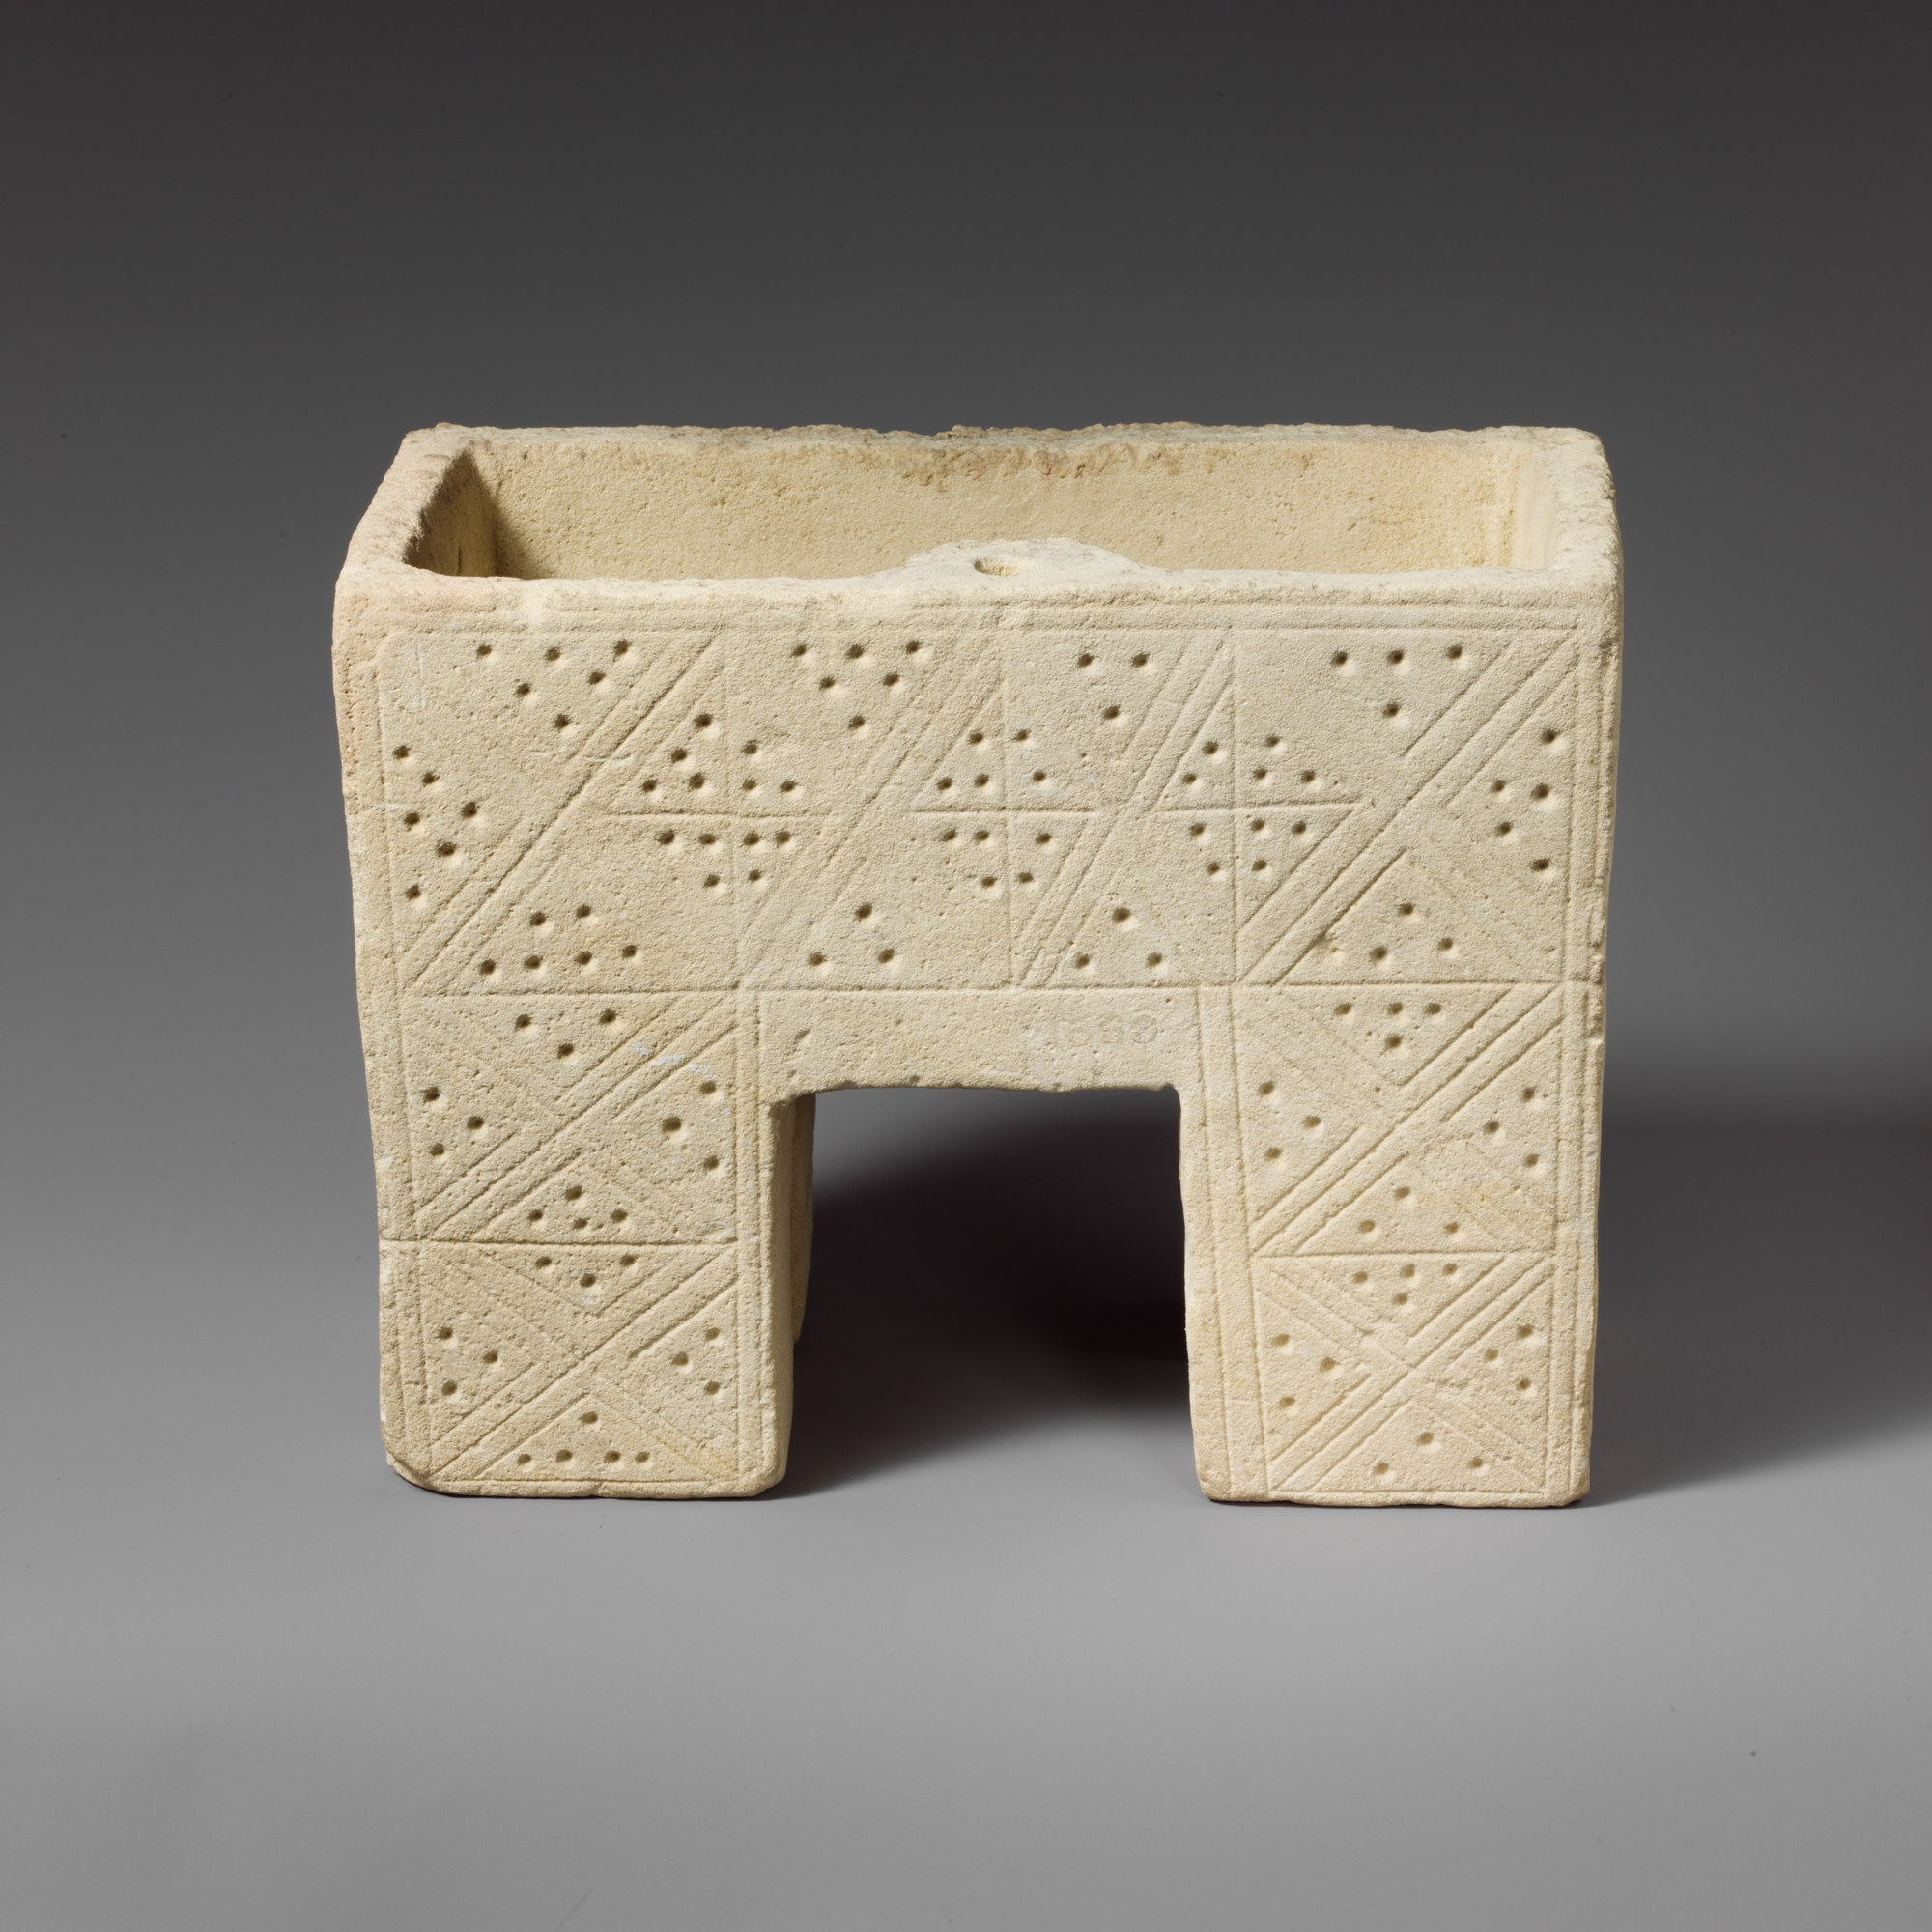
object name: chest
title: Limestone chest with incised decoration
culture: cypriot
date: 800-701 BCE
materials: chalk, limestone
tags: chests